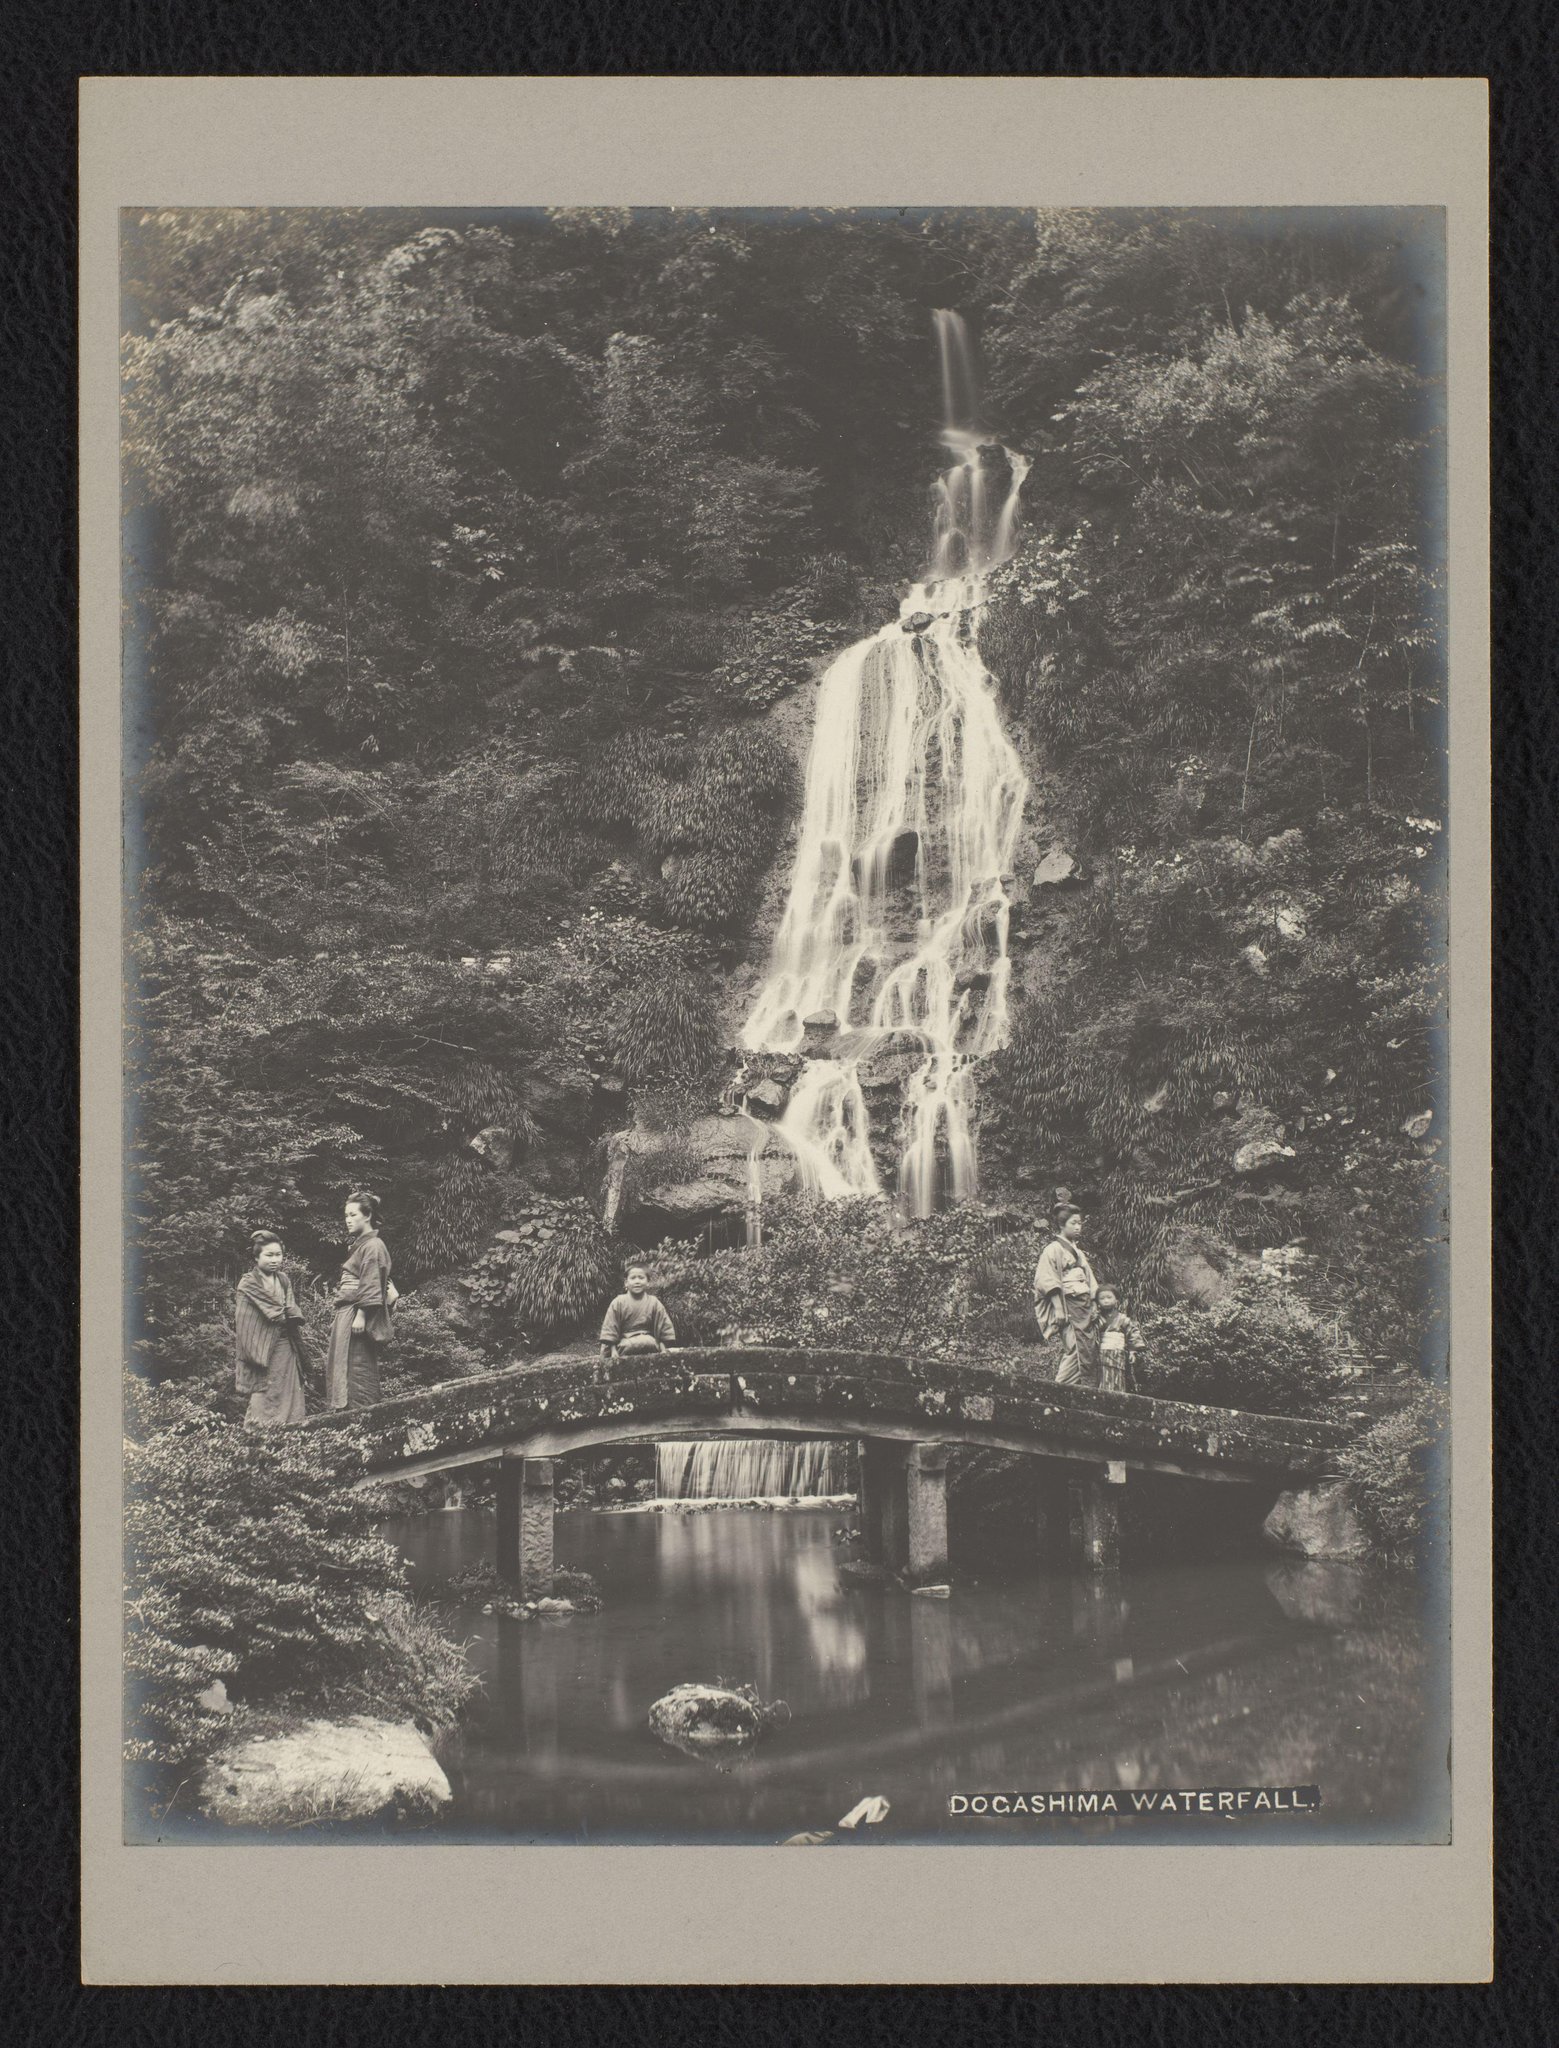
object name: photograph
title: Dogashima waterfall.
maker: Anonymous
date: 1895-1915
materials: cardboard, photographic support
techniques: gelatin silver print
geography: kanagawa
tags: kanagawa-ken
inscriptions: number: ‘19.’